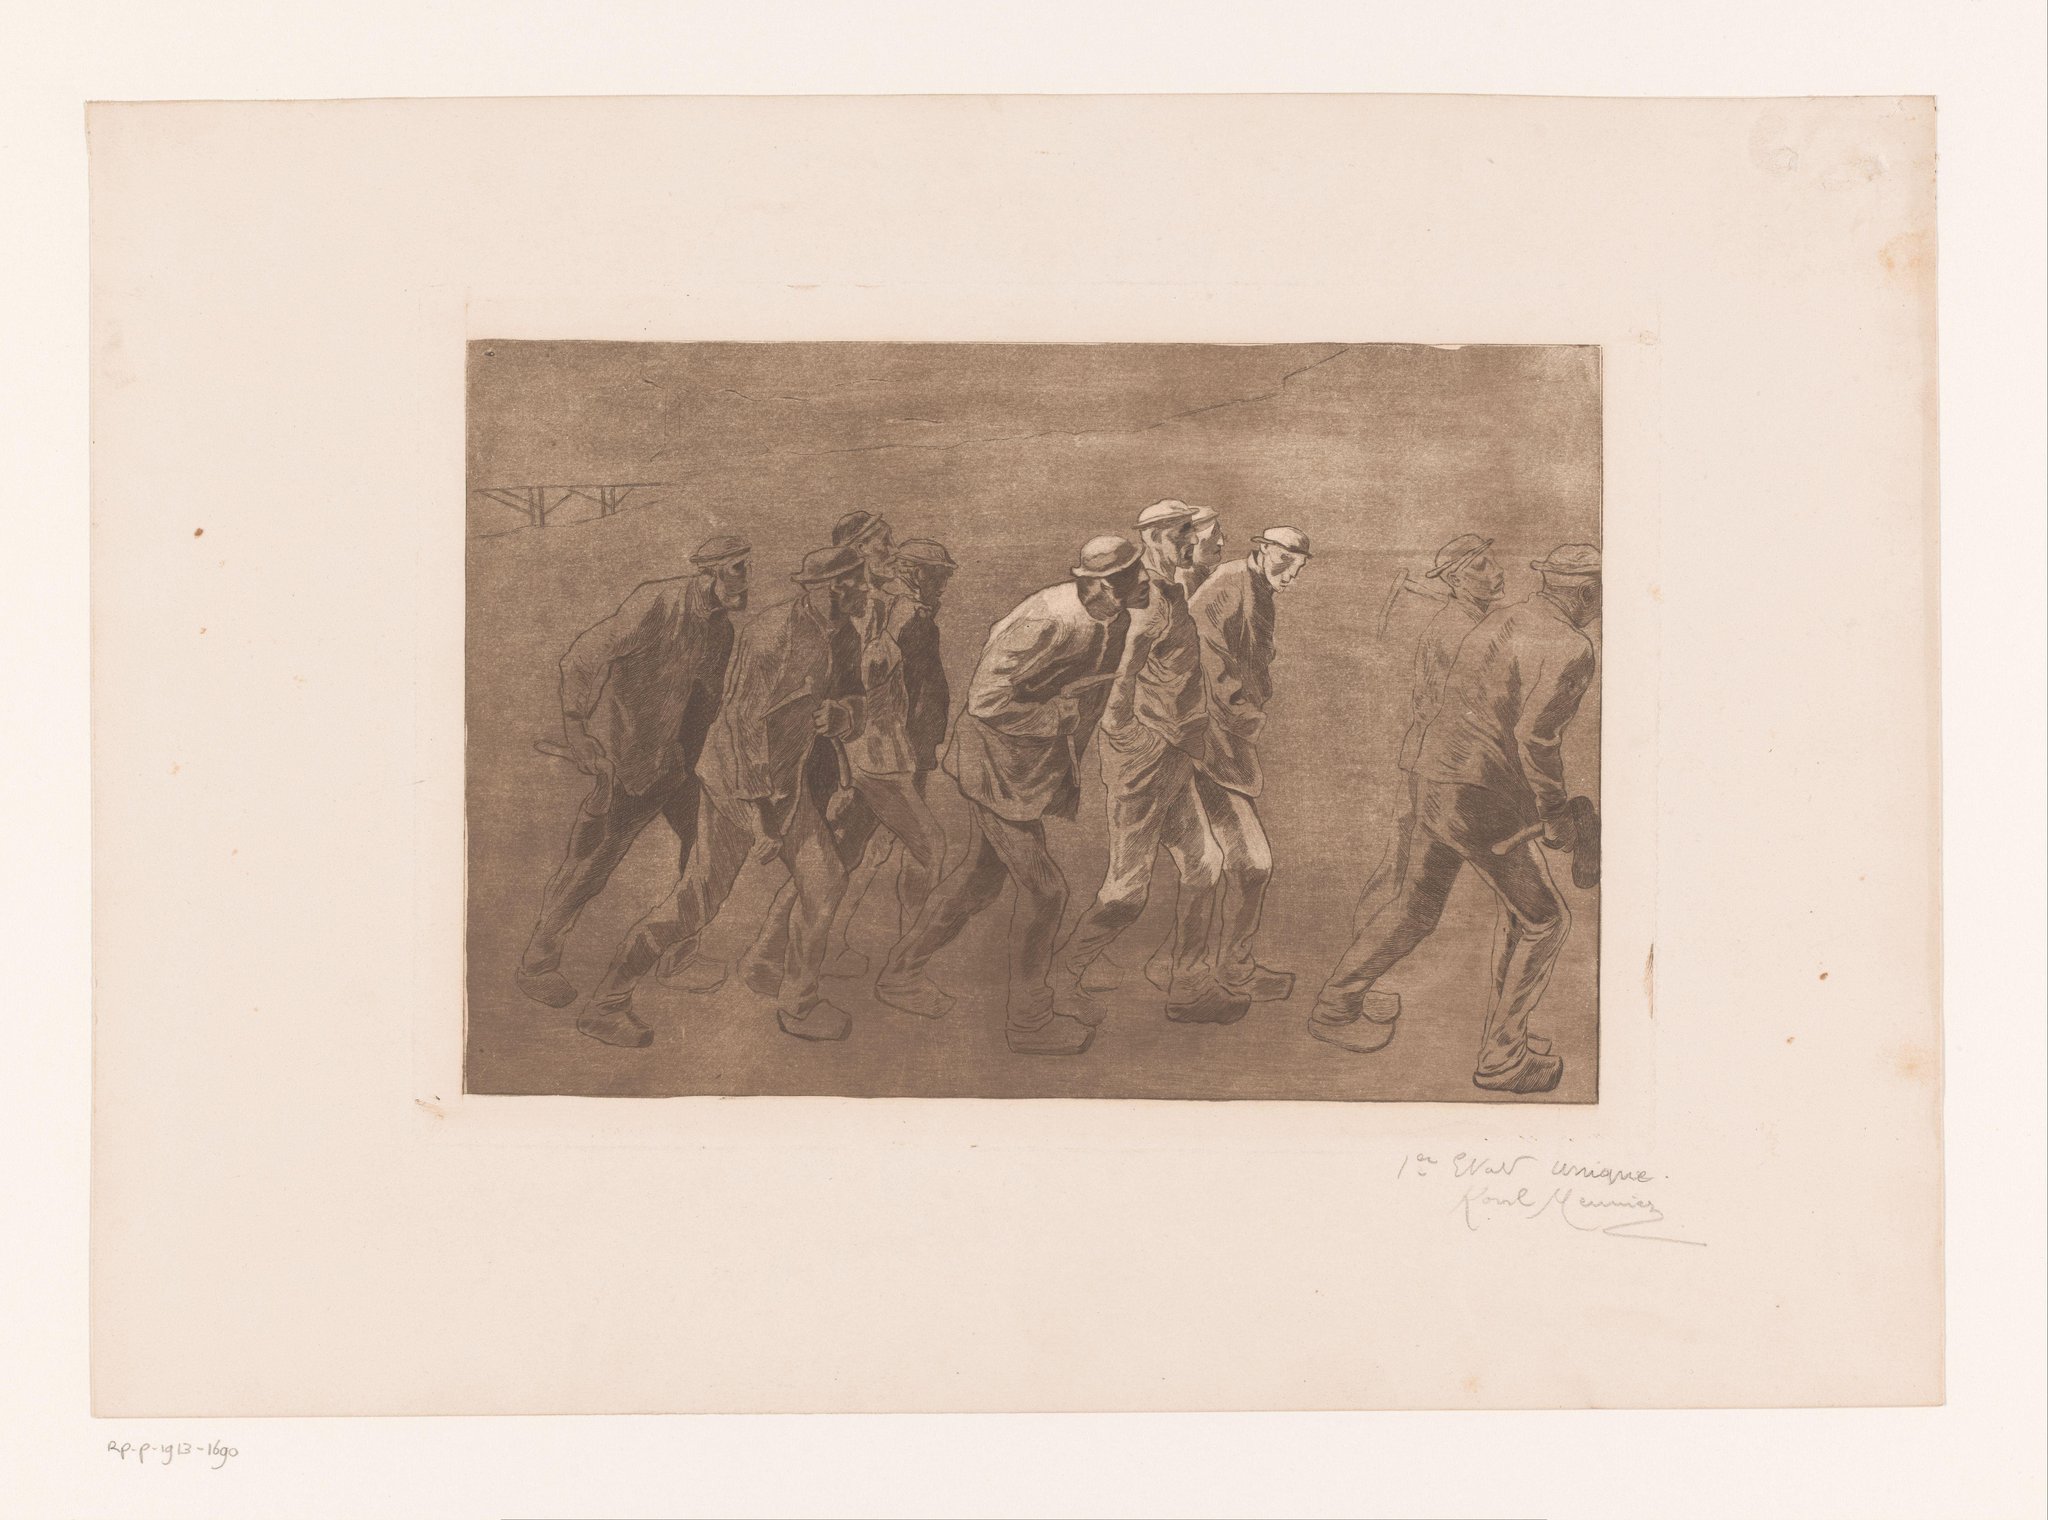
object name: print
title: Tien mijnwerkers op weg naar hun werk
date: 1874-1894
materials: paper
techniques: aquatint, etching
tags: miner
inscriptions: collector's mark: Lugt 2228, inscription: ‘1er Etat unique’